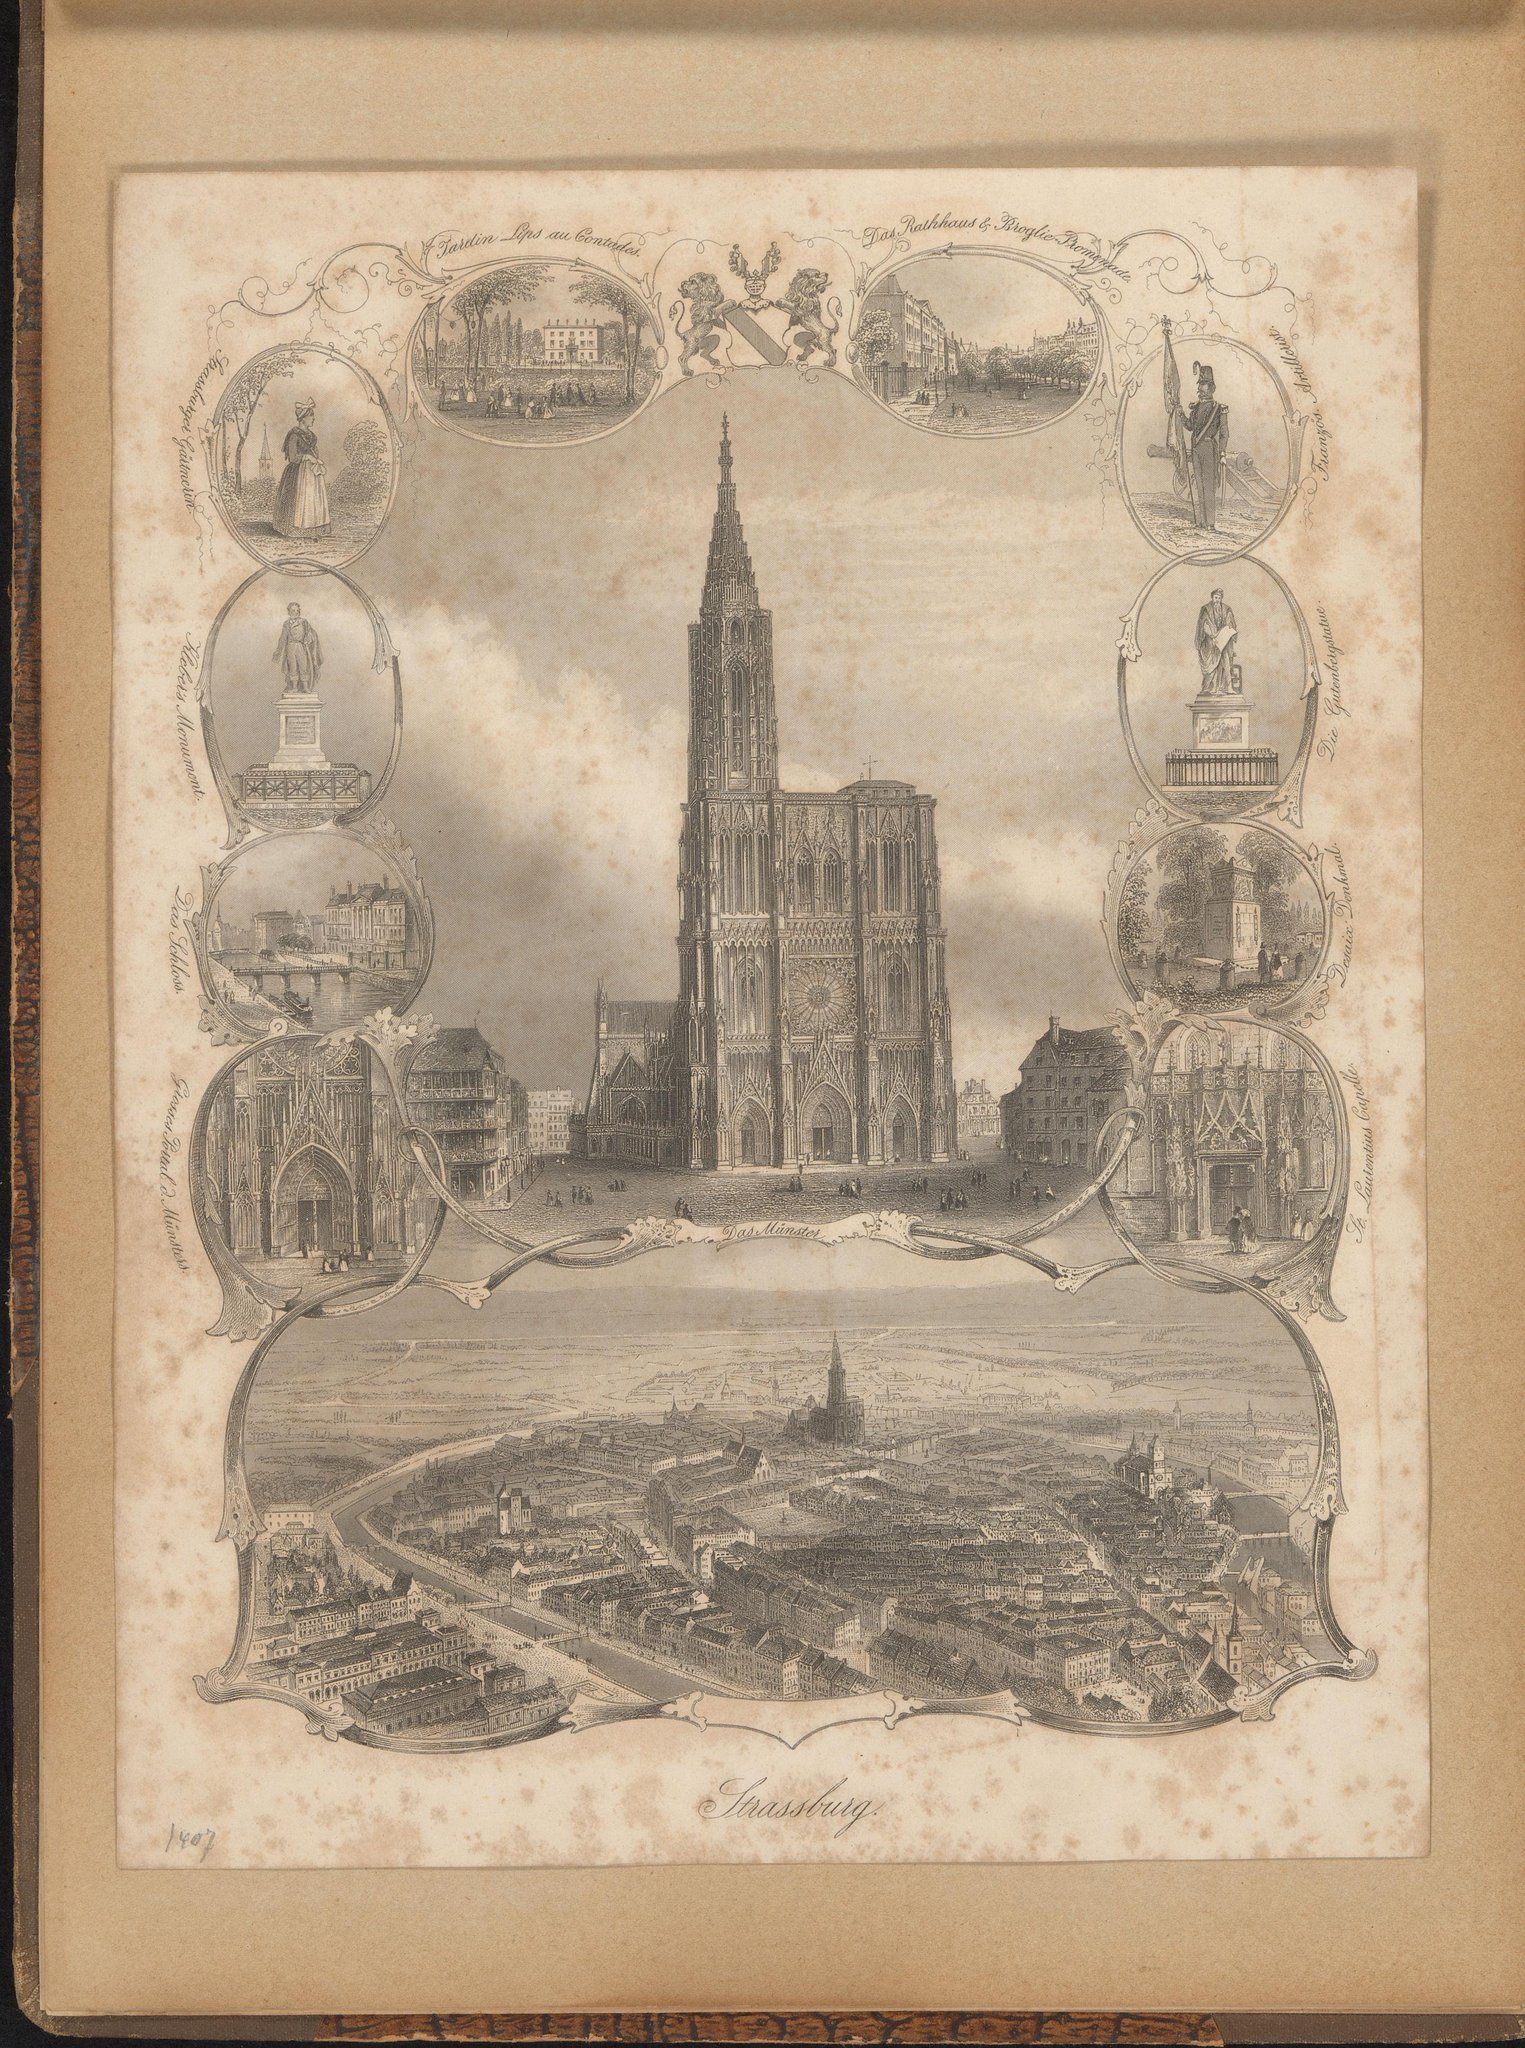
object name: print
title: Strassburg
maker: Anonymous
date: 1870-1910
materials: paper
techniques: engraving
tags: willy moos, city-view in general; 'veduta', church (exterior)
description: Gezichten van Straatsburg en de kathedraal. Losse prent achterin het fotoalbum van een reis van Willy Moos naar Canada en de Verenigde Staten in 1909.